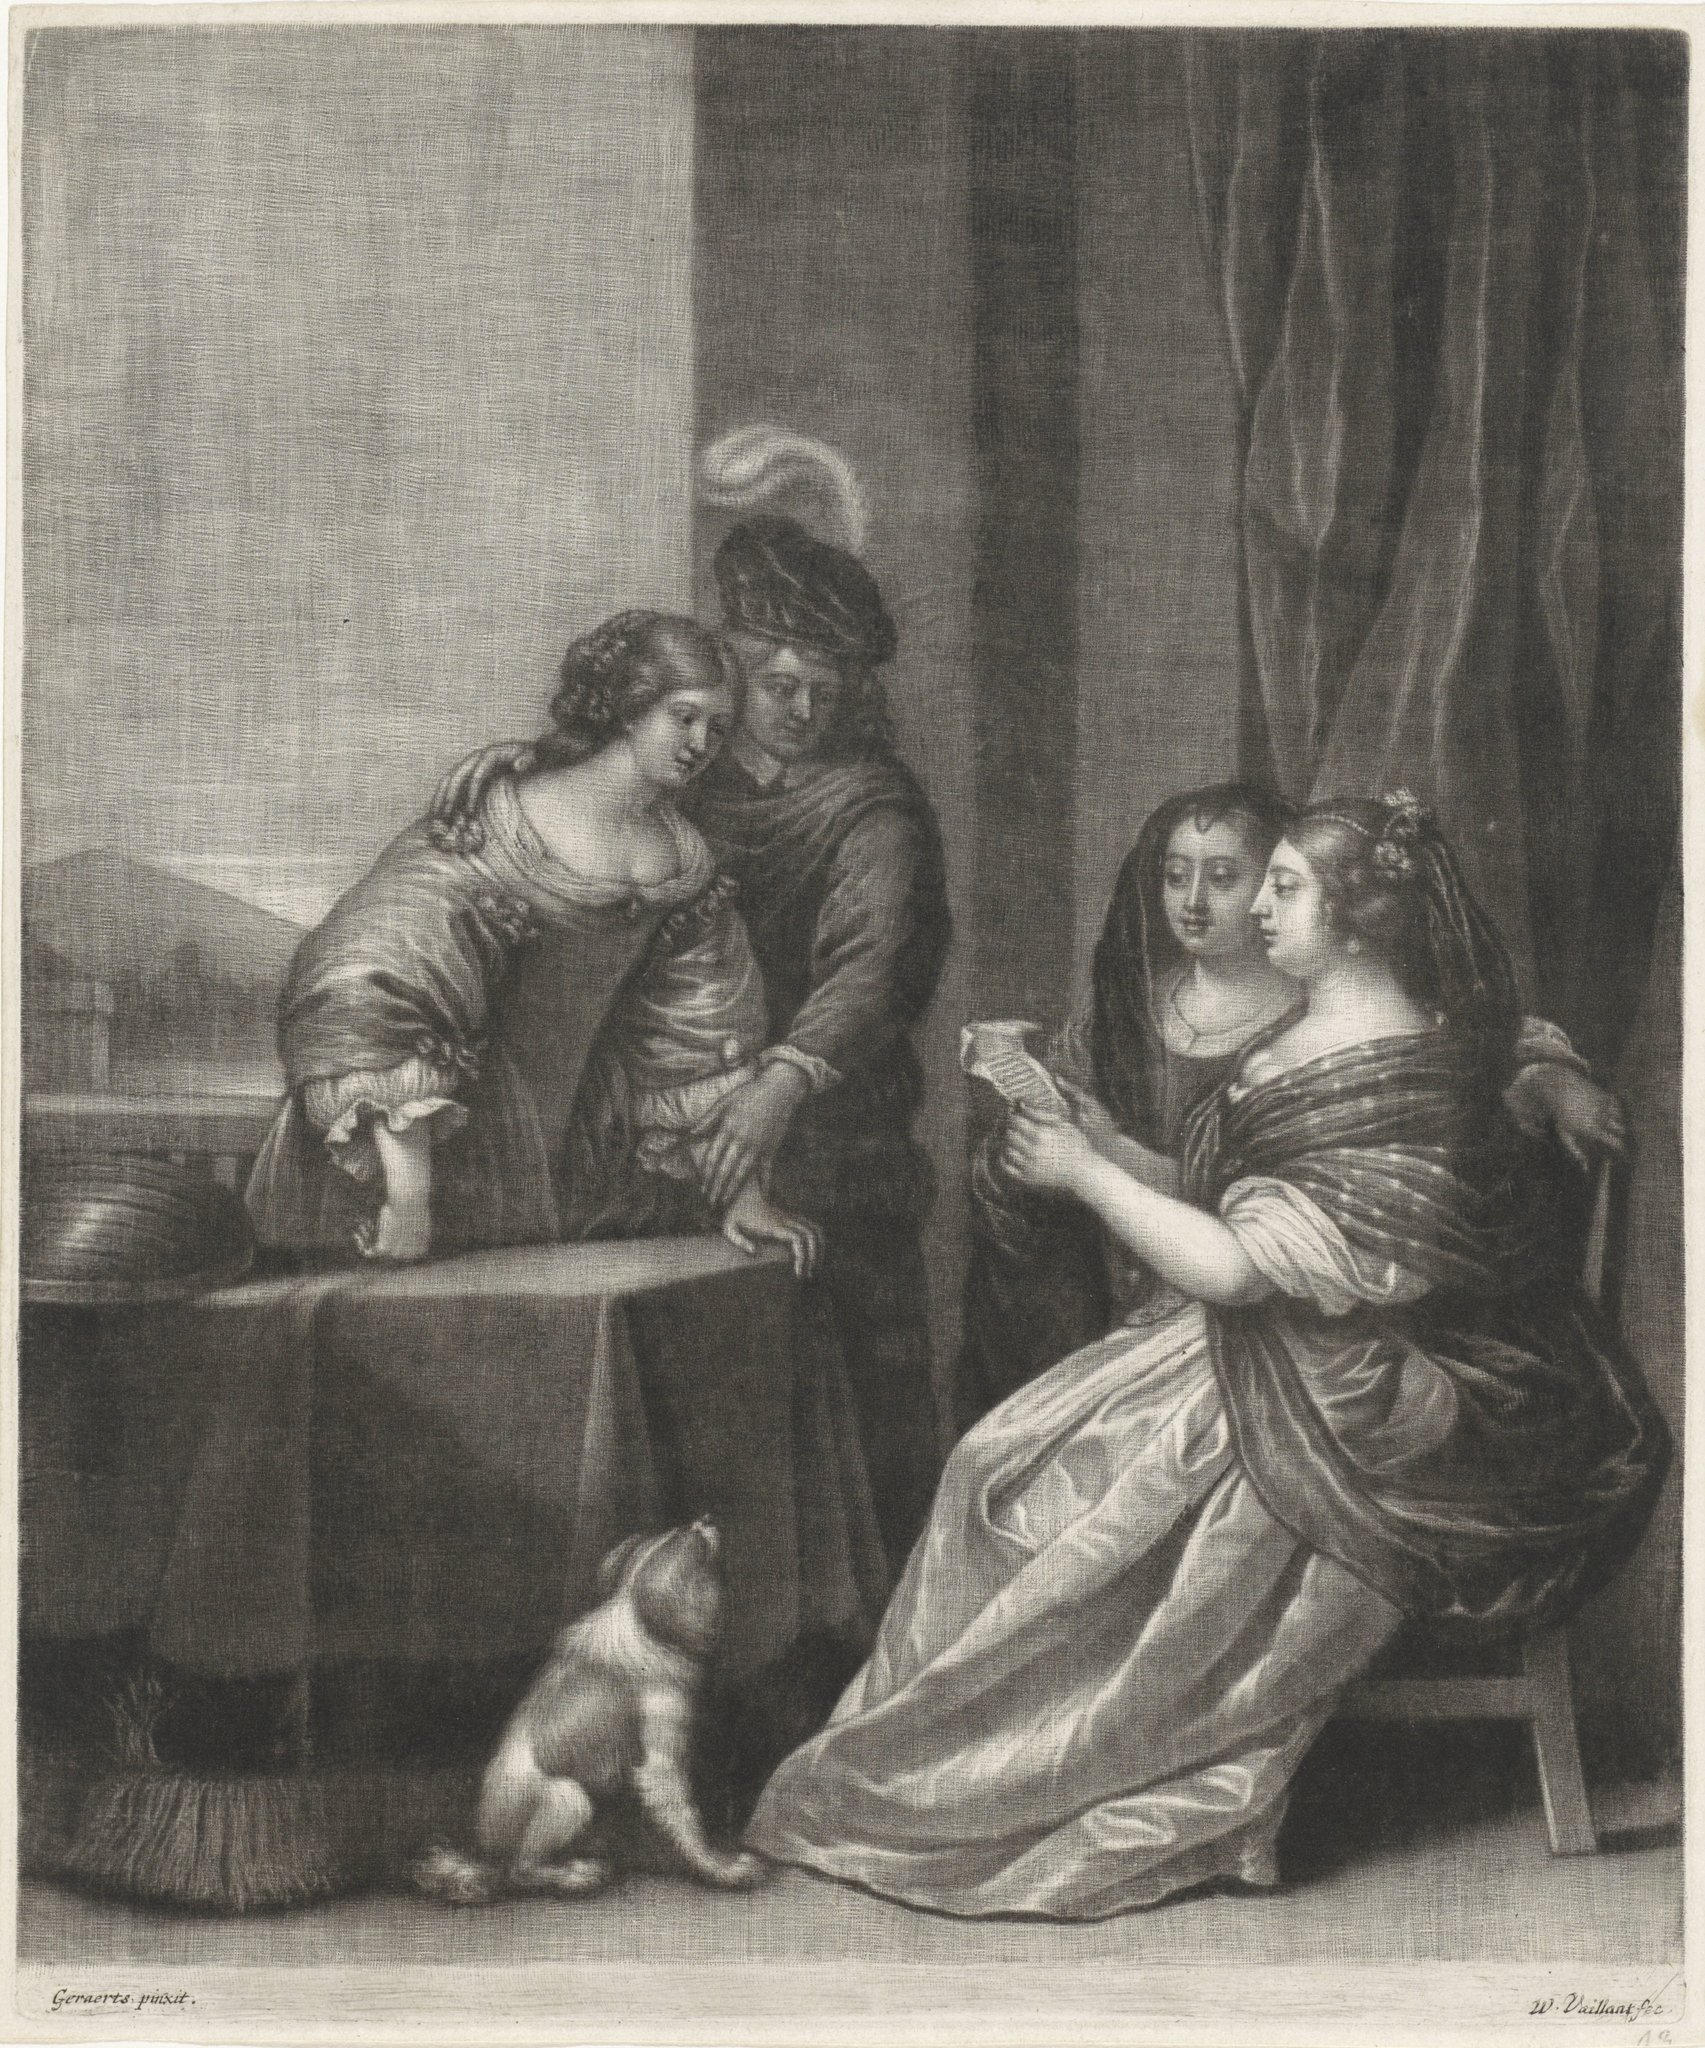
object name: print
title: Brieflezende vrouw op een terras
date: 1658-1677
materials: paper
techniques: mezzotint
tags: reading, landscapes, letter, envelope, dog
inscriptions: collector's mark: Lugt 240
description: Op een terras leest een vrouw een brief voor aan twee andere vrouwen en een man. Voor haar zit een hondje. Op de achtergrond een glooiend landschap.